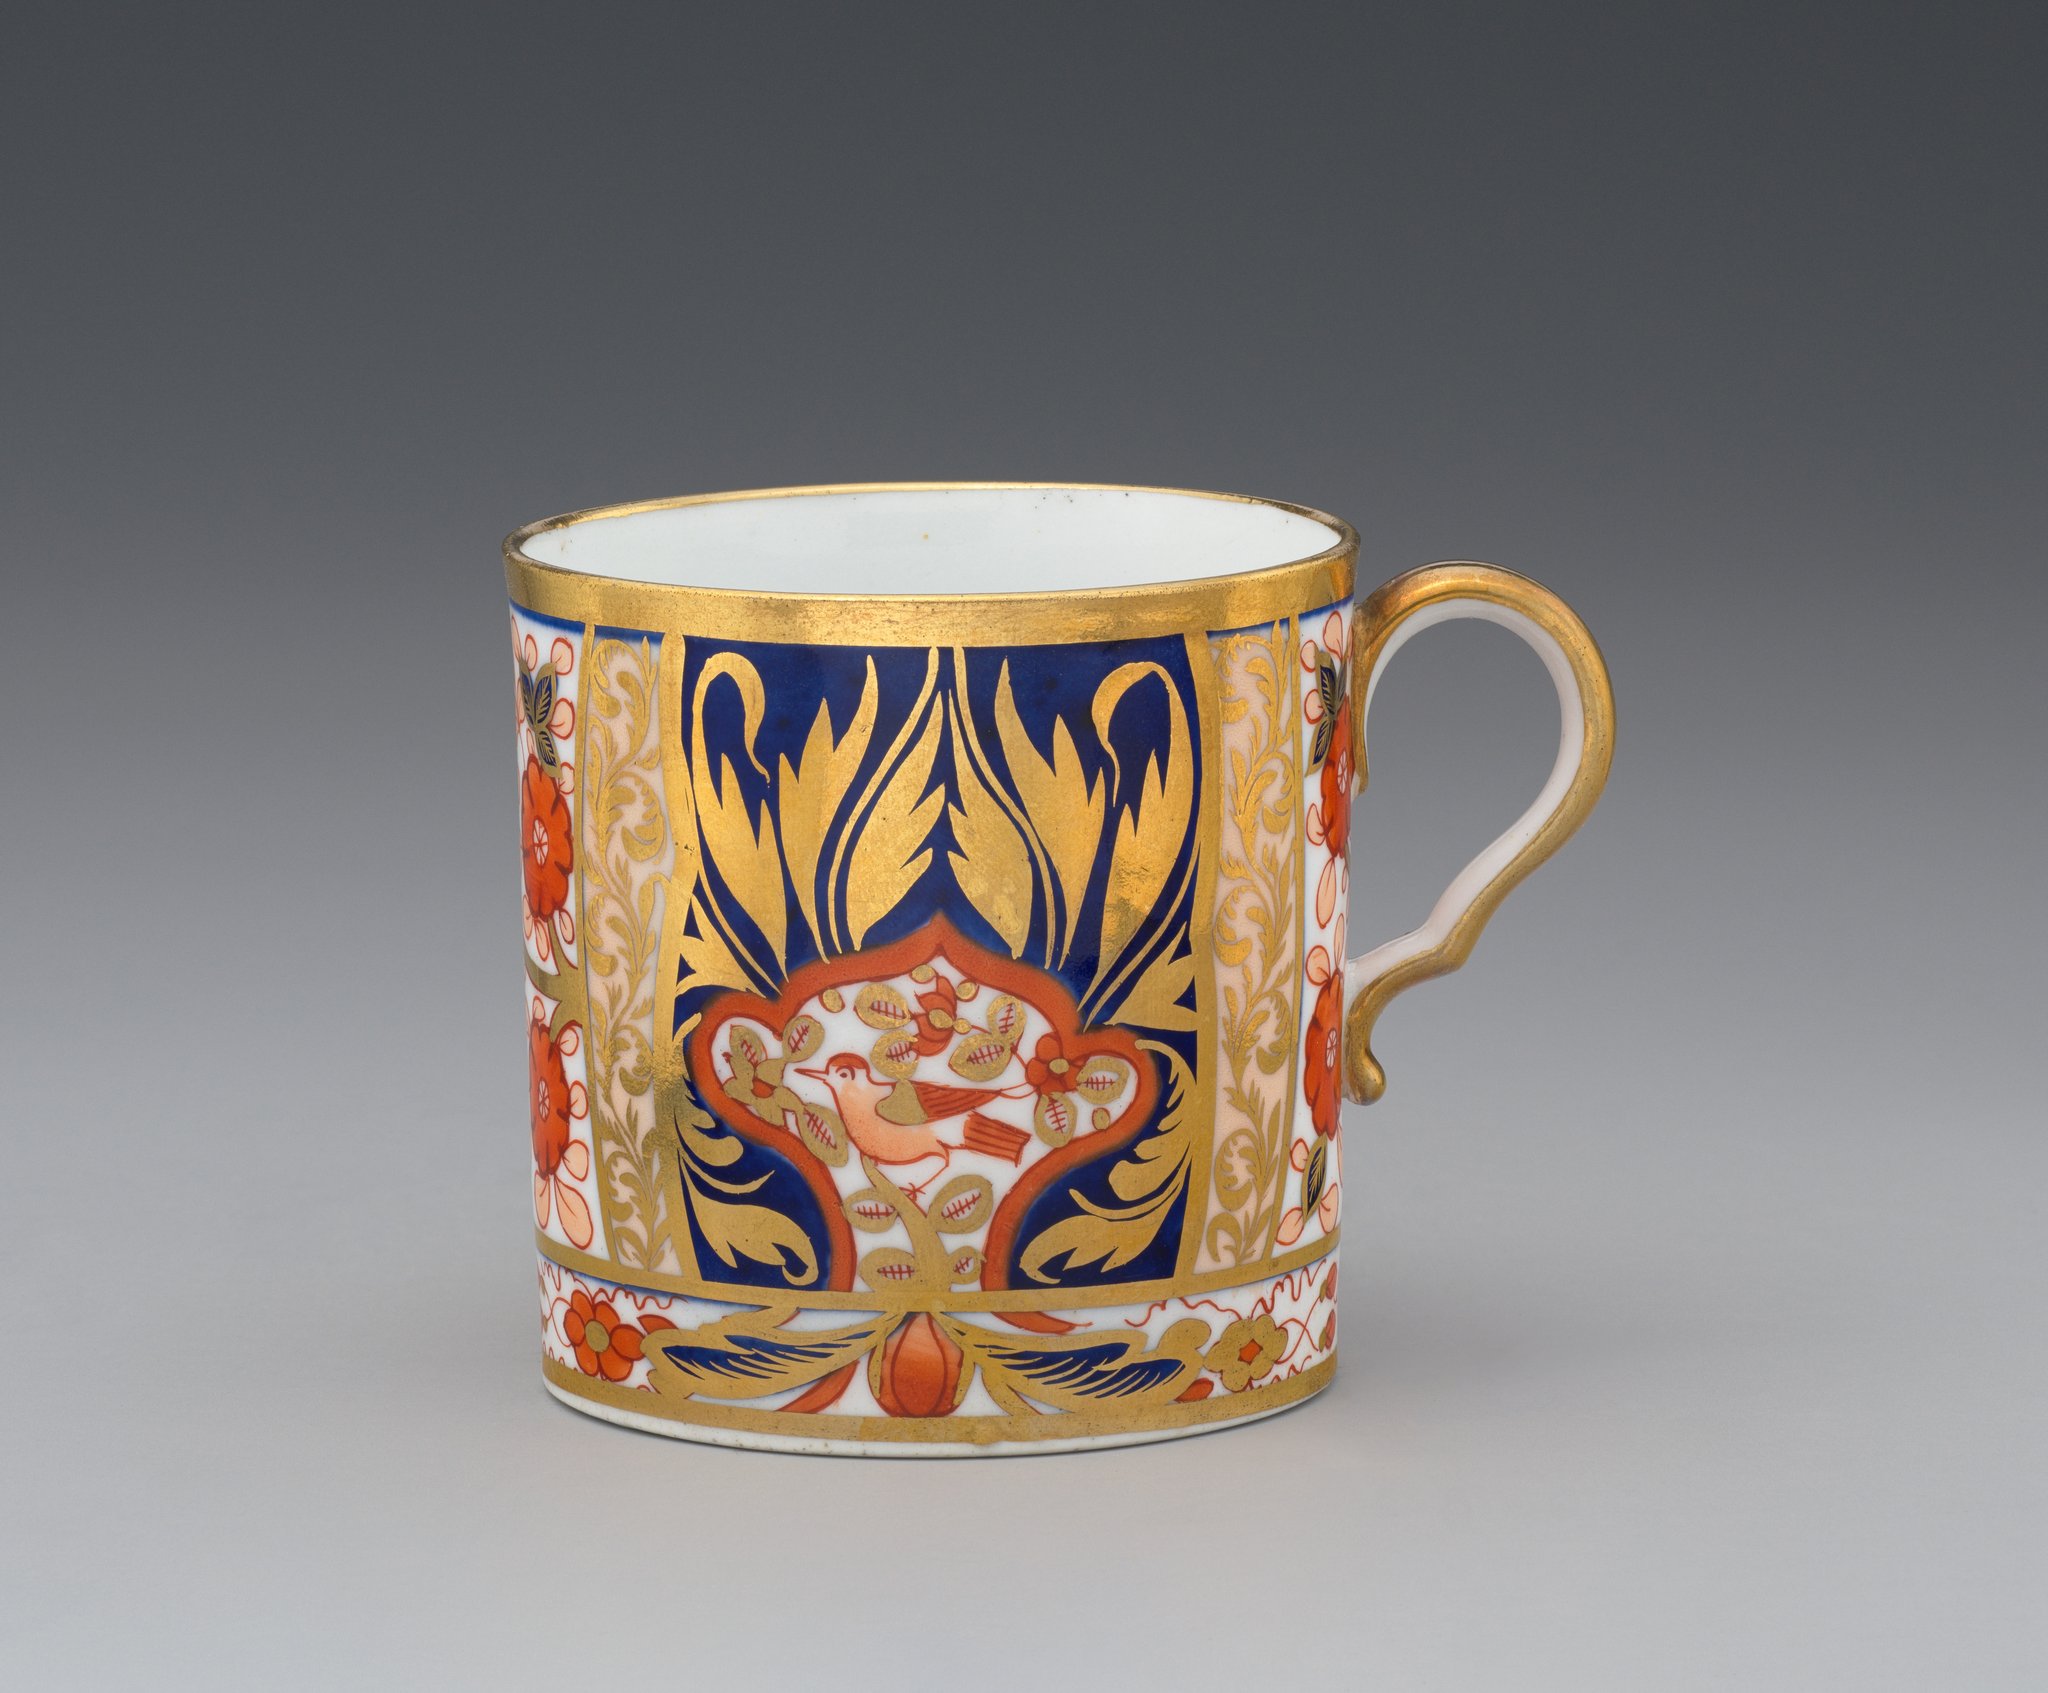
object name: cup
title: Cup (part of a service)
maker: j. spode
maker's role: factory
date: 1800-1830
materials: soft paste porcelain